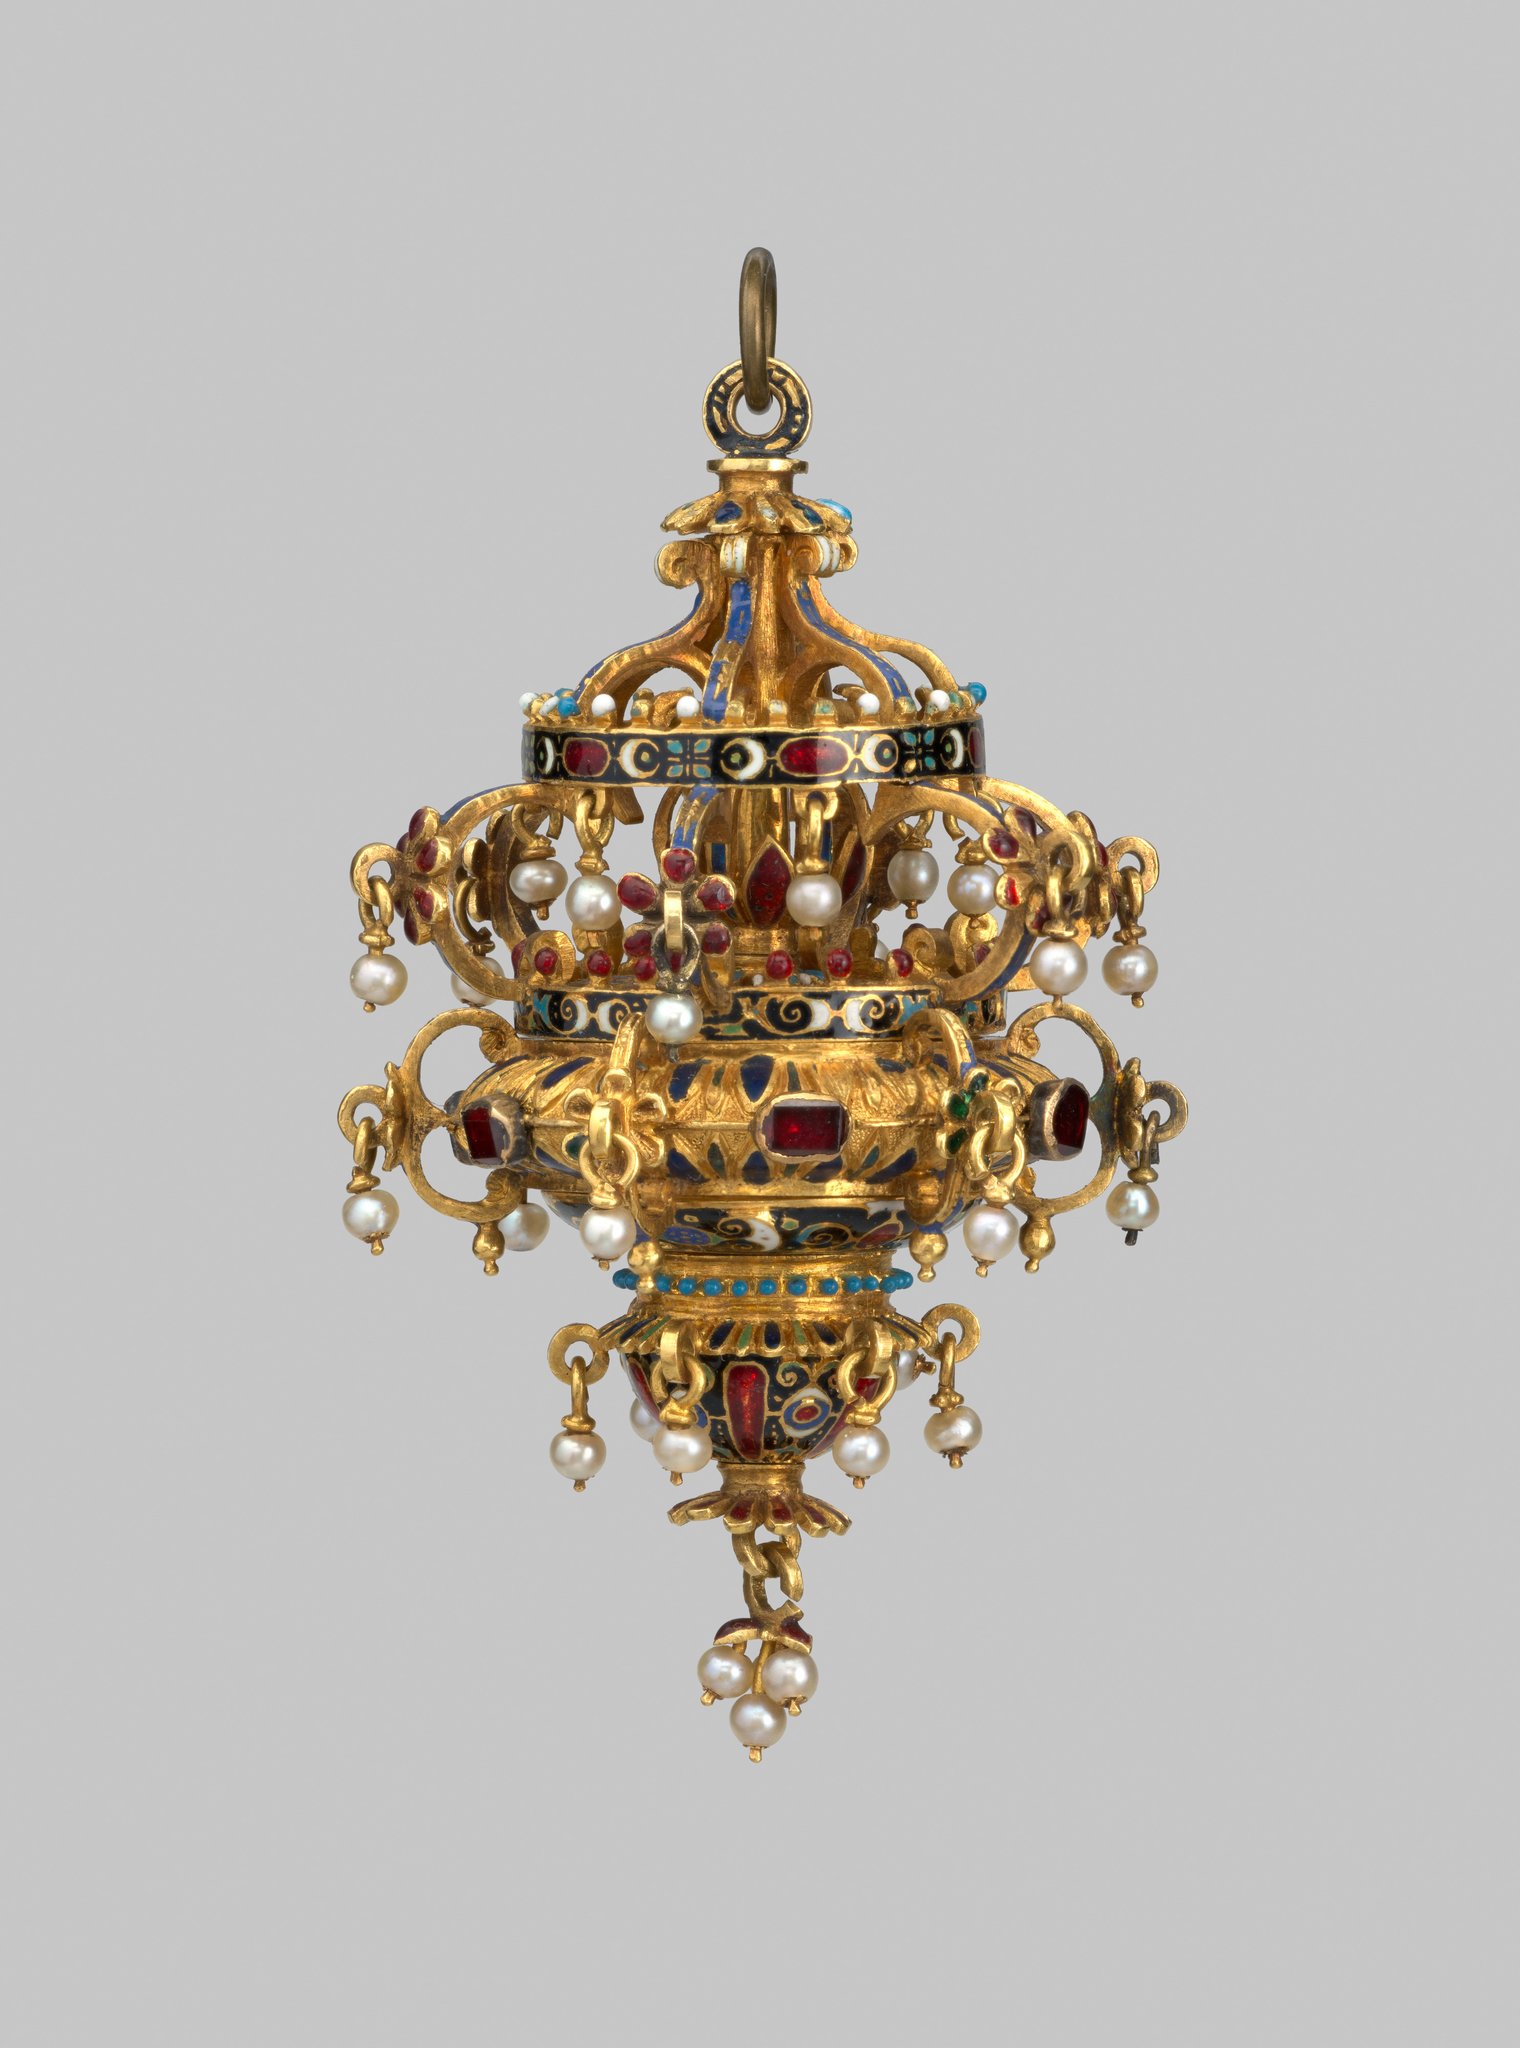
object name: pendant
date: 1551-1600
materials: enamel, gold, pearl, gemstone